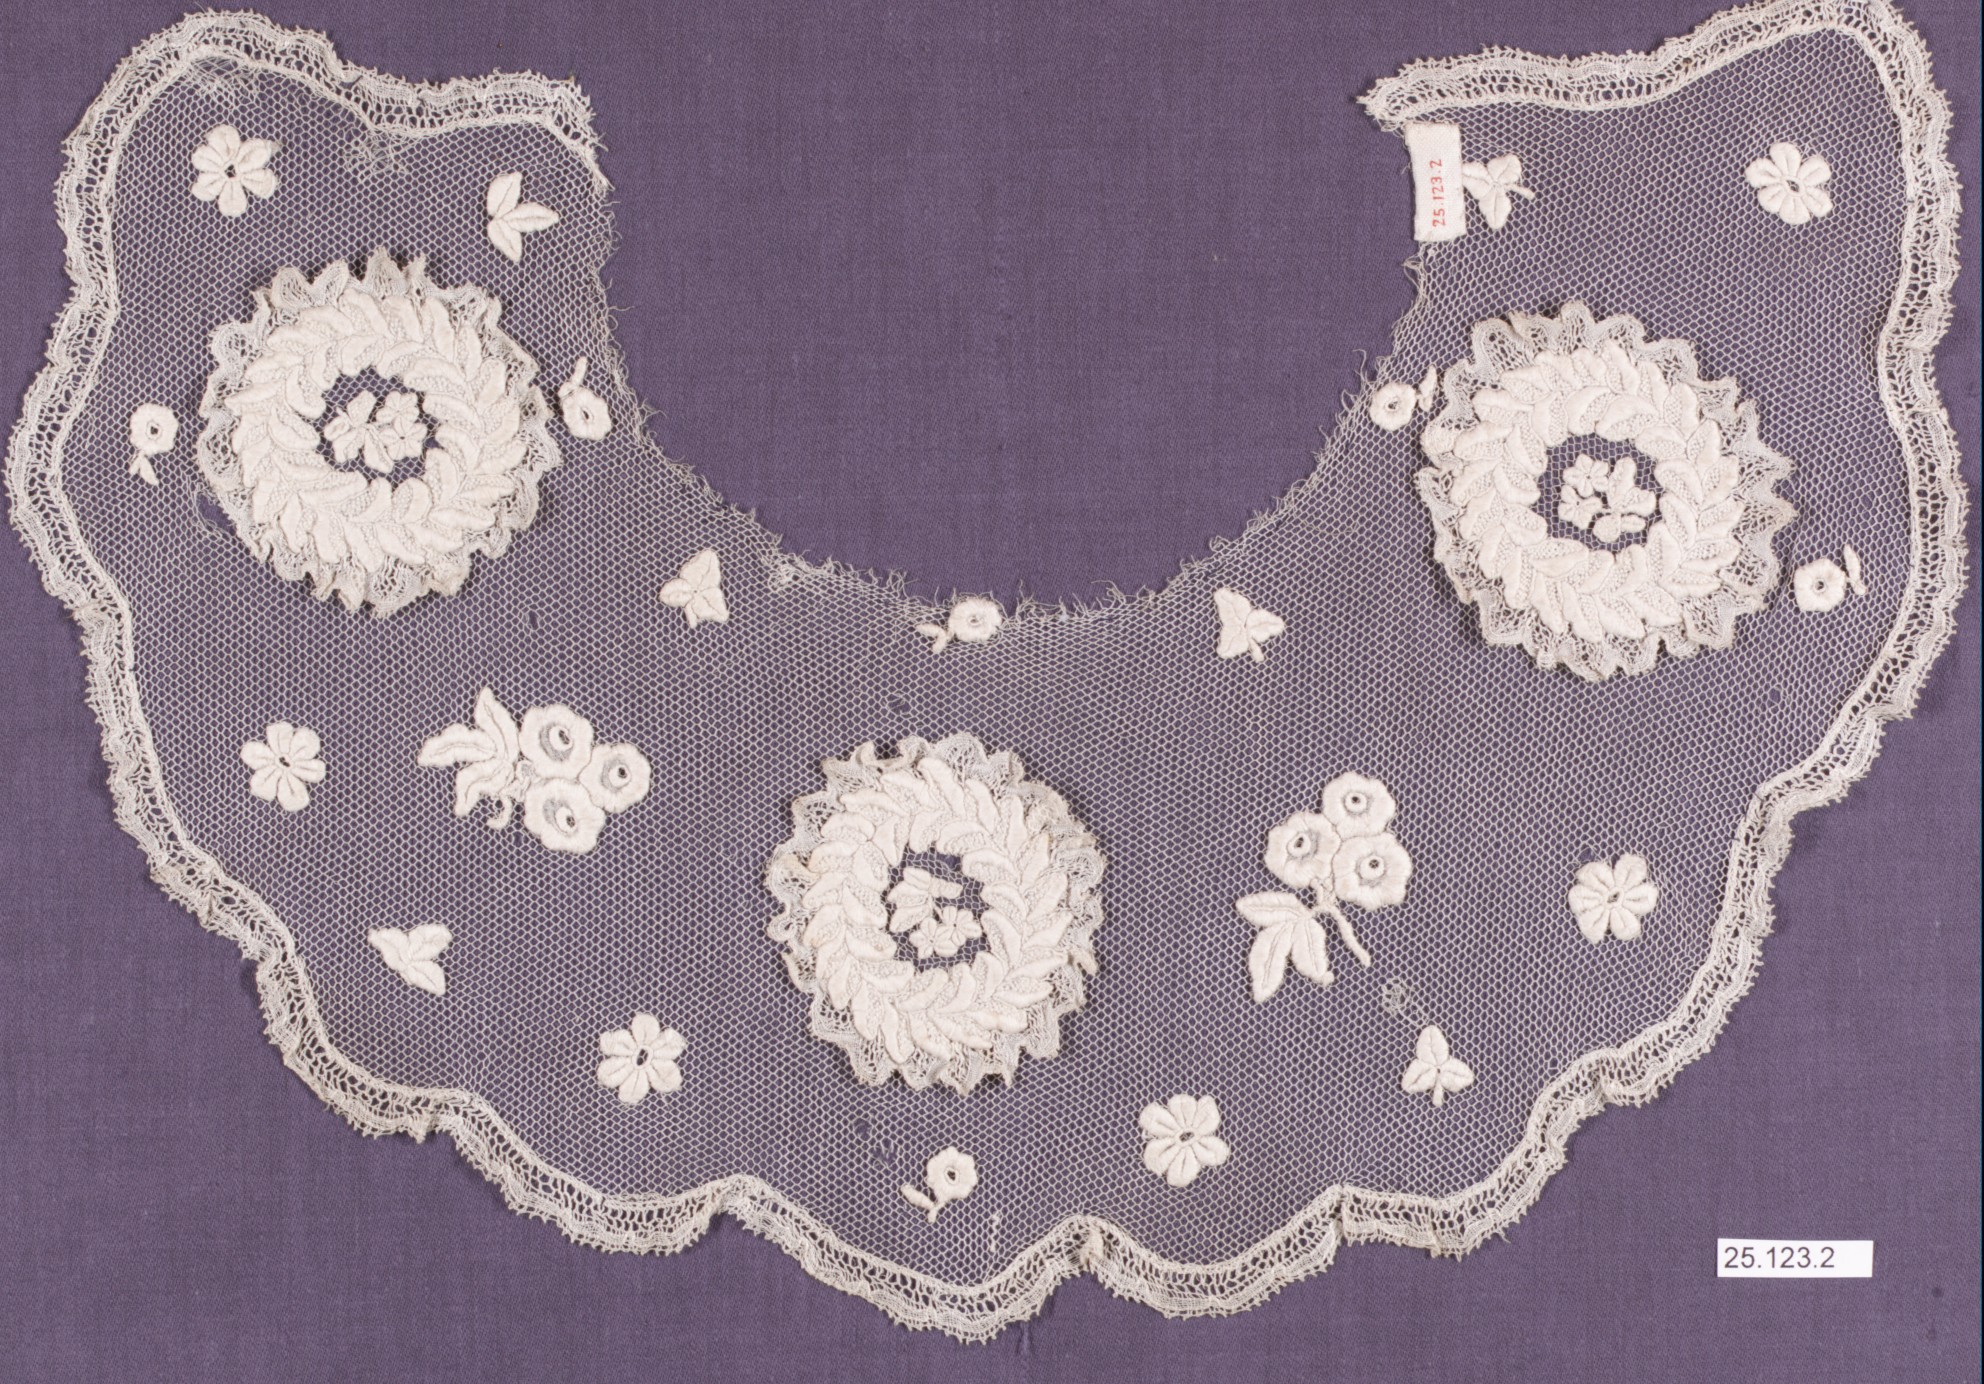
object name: collar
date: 1801-1900